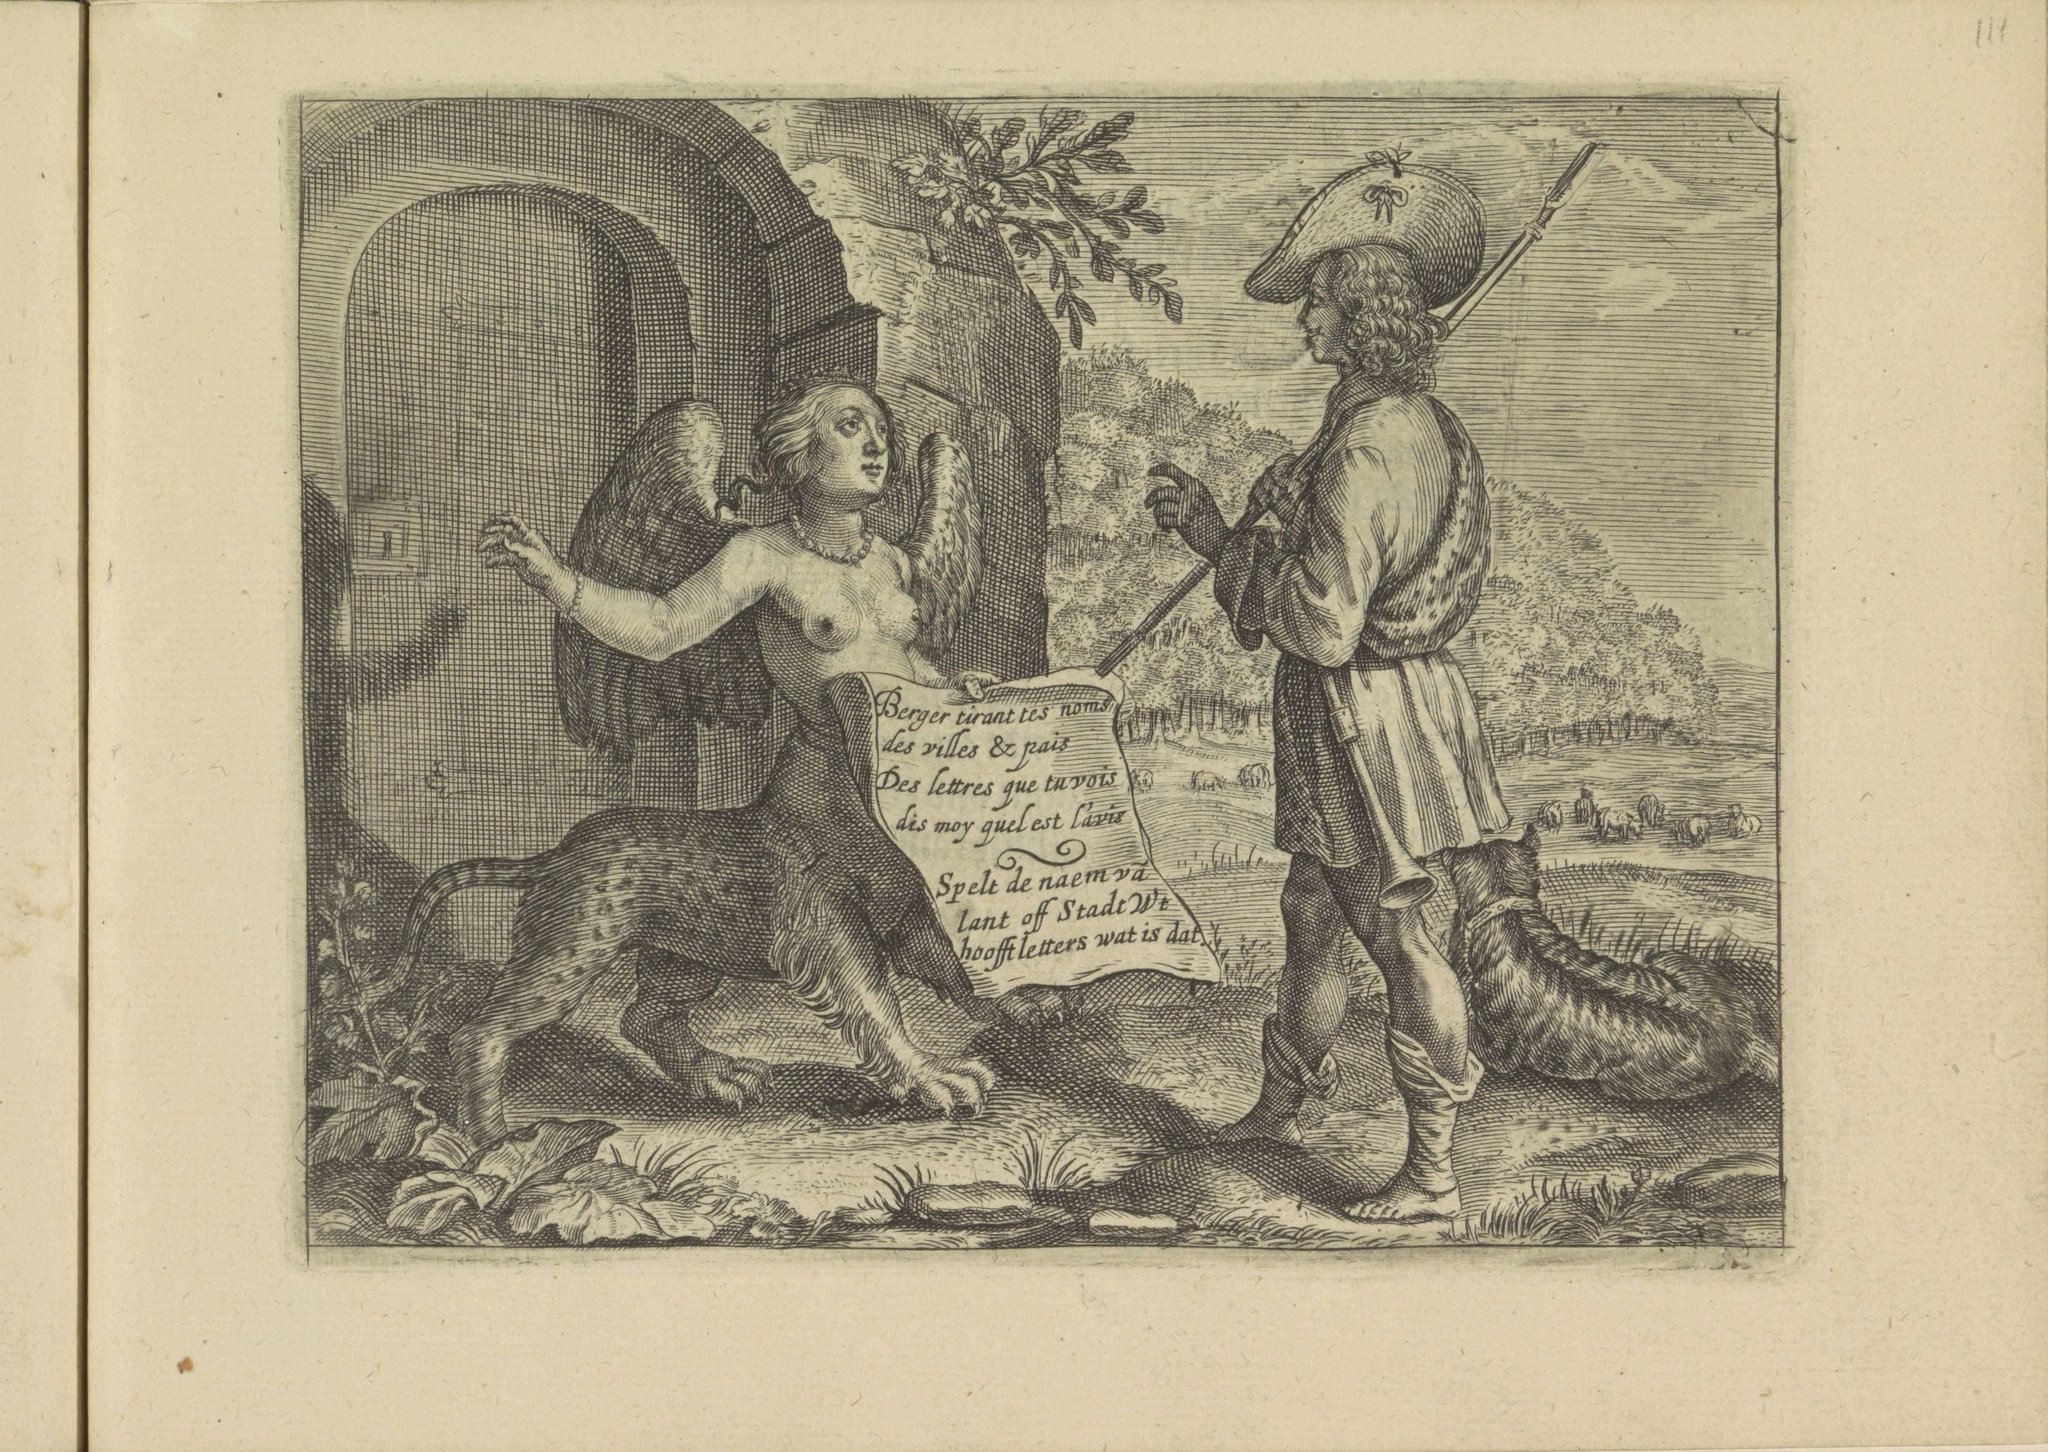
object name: album leaf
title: Les vrais pourtraits de quelques unes des plus grandes dames de la chrestiente desguisees en bergeres.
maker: crispijn van de passe (ii)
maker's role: draughtsman, print maker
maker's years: 1594-1670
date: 1640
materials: paper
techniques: engraving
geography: amsterdam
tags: sphinx (lion/woman); 'sfinge' (ripa), herding, herdsman, herdswoman, shepherd, shepherdess, cowherd, etc.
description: Een sfinx staat voor een deur en toont een herder een vel papier met een Franstalige en Nederlandstalige tekst: ... Spelt de naem van lant off stadt uut hoofftletters wat is dat. Naast de herder een hond. Daarachter een graslandschap met schapen. Het blad maakt deel uit van een album.